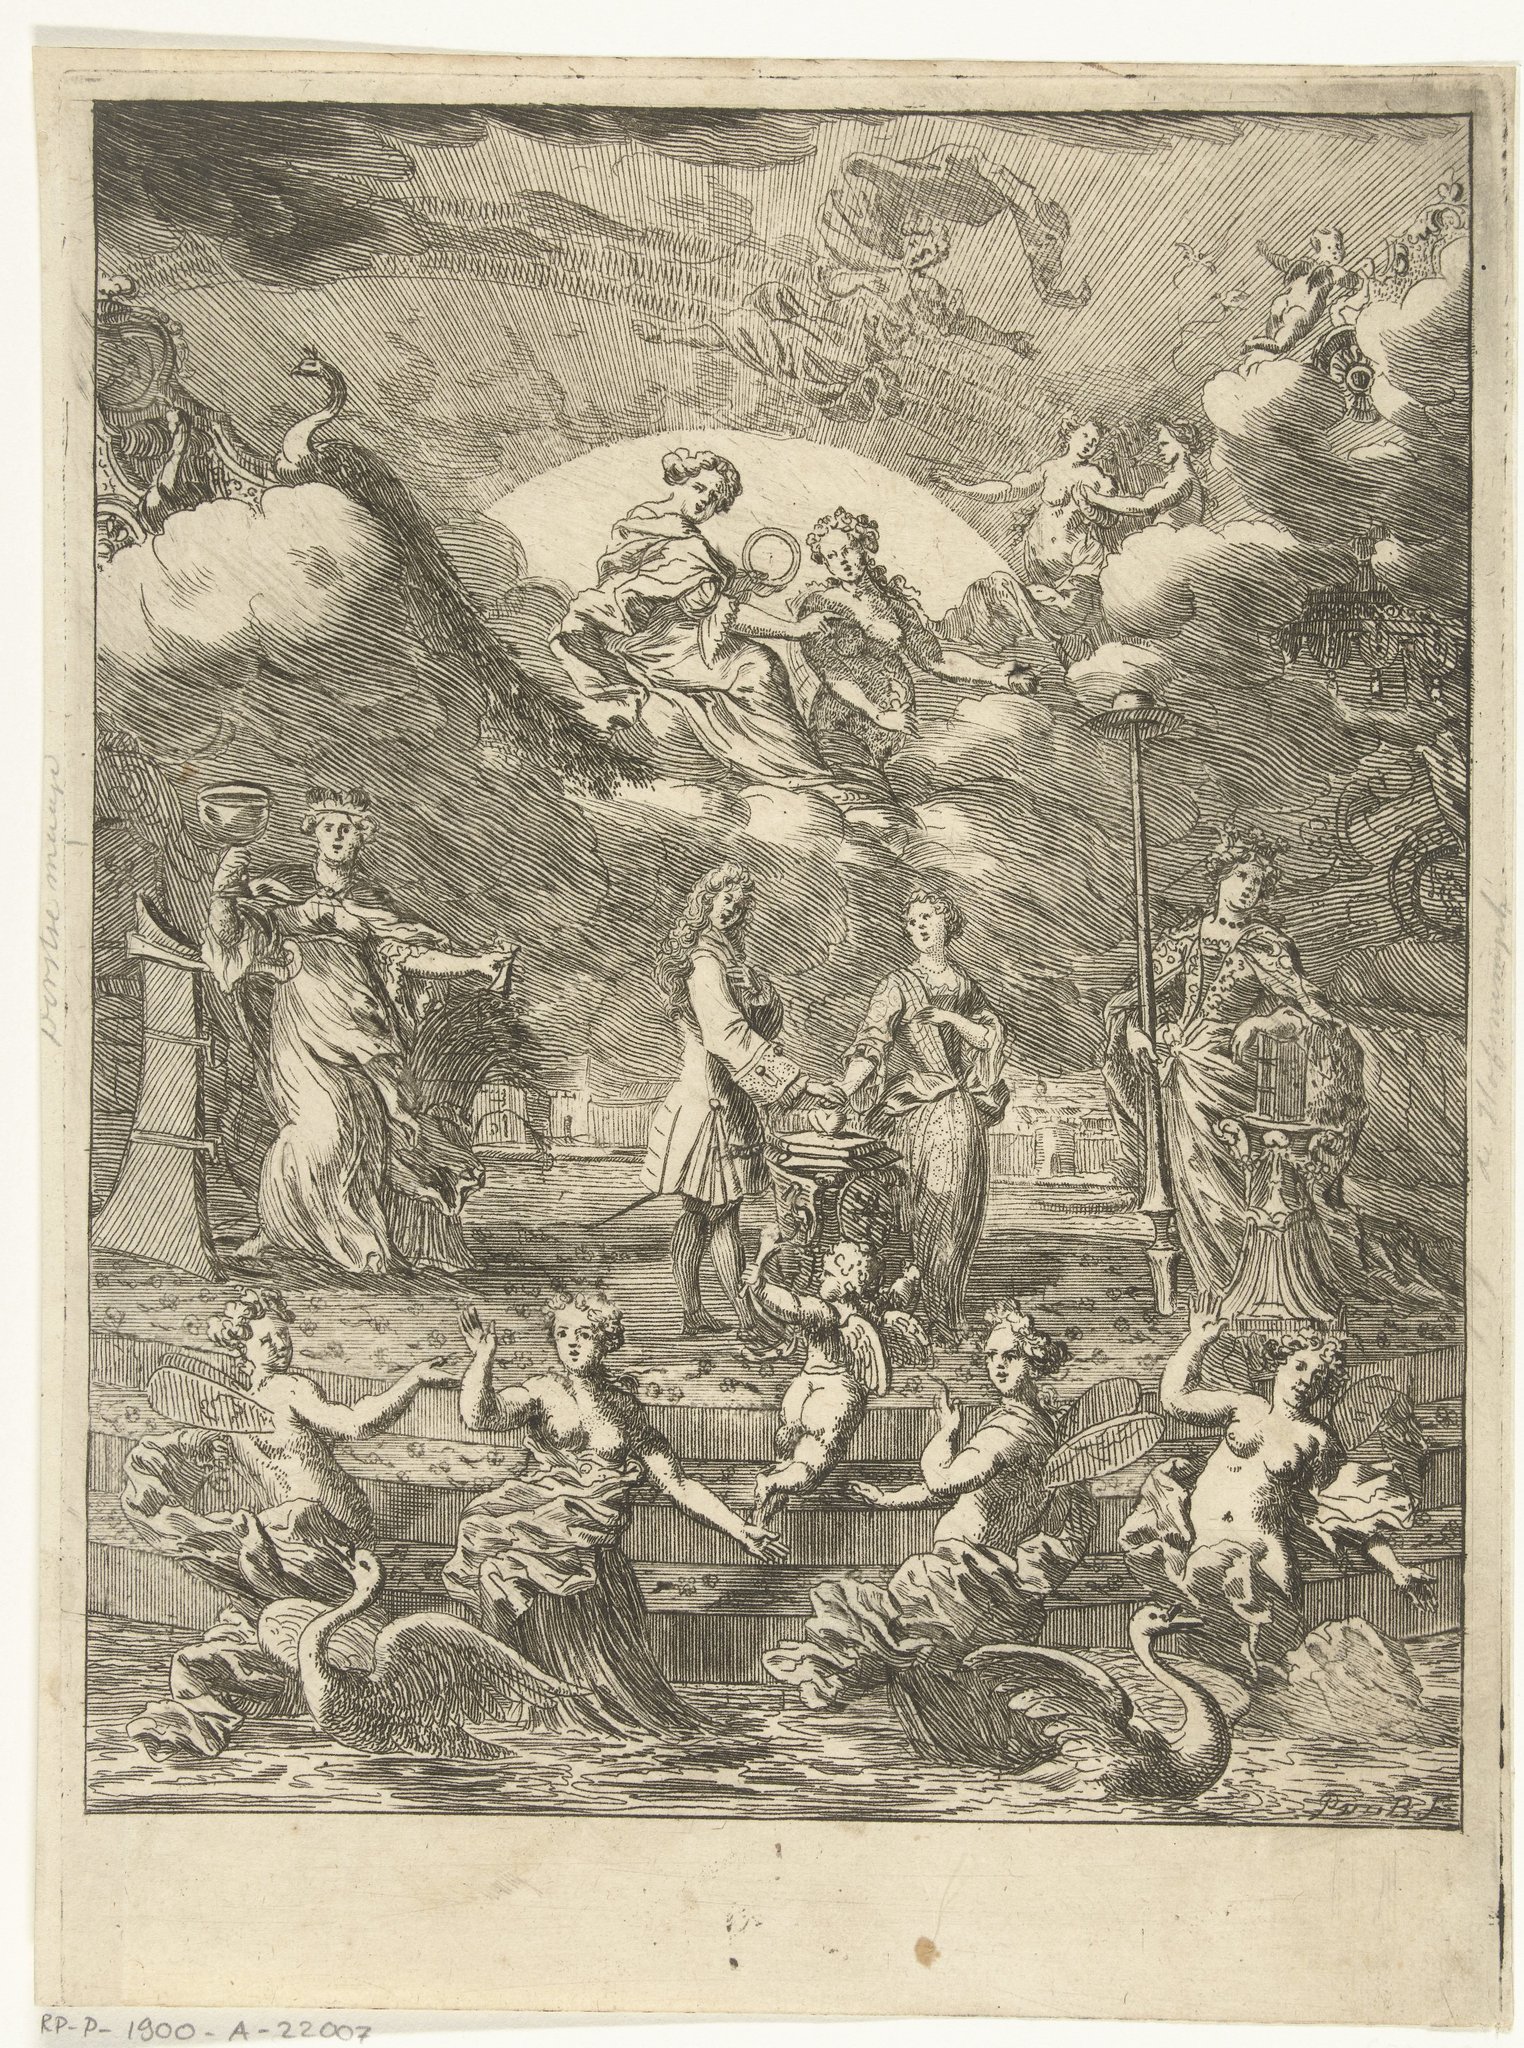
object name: print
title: Allegorie op het huwelijk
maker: pieter van den berge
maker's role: draughtsman, print maker, printer, publisher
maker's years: 1659-1737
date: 1694-1737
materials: paper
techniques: etching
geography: amsterdam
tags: (civil) marriage ceremonies (+ variant)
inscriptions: collector's mark: Lugt 2228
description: In het midden staan de bruid en bruidegom. Zij reiken elkander de hand boven een altaar, waarop twee harten staan. Rechts van deze groep staat de Hollandsche Maagd. Op den voorgrond vier waternimfen en Amor die zich met een brandende fakkel naar het altaar begeeft om de zich daarop bevindende harten te doen ontbranden.